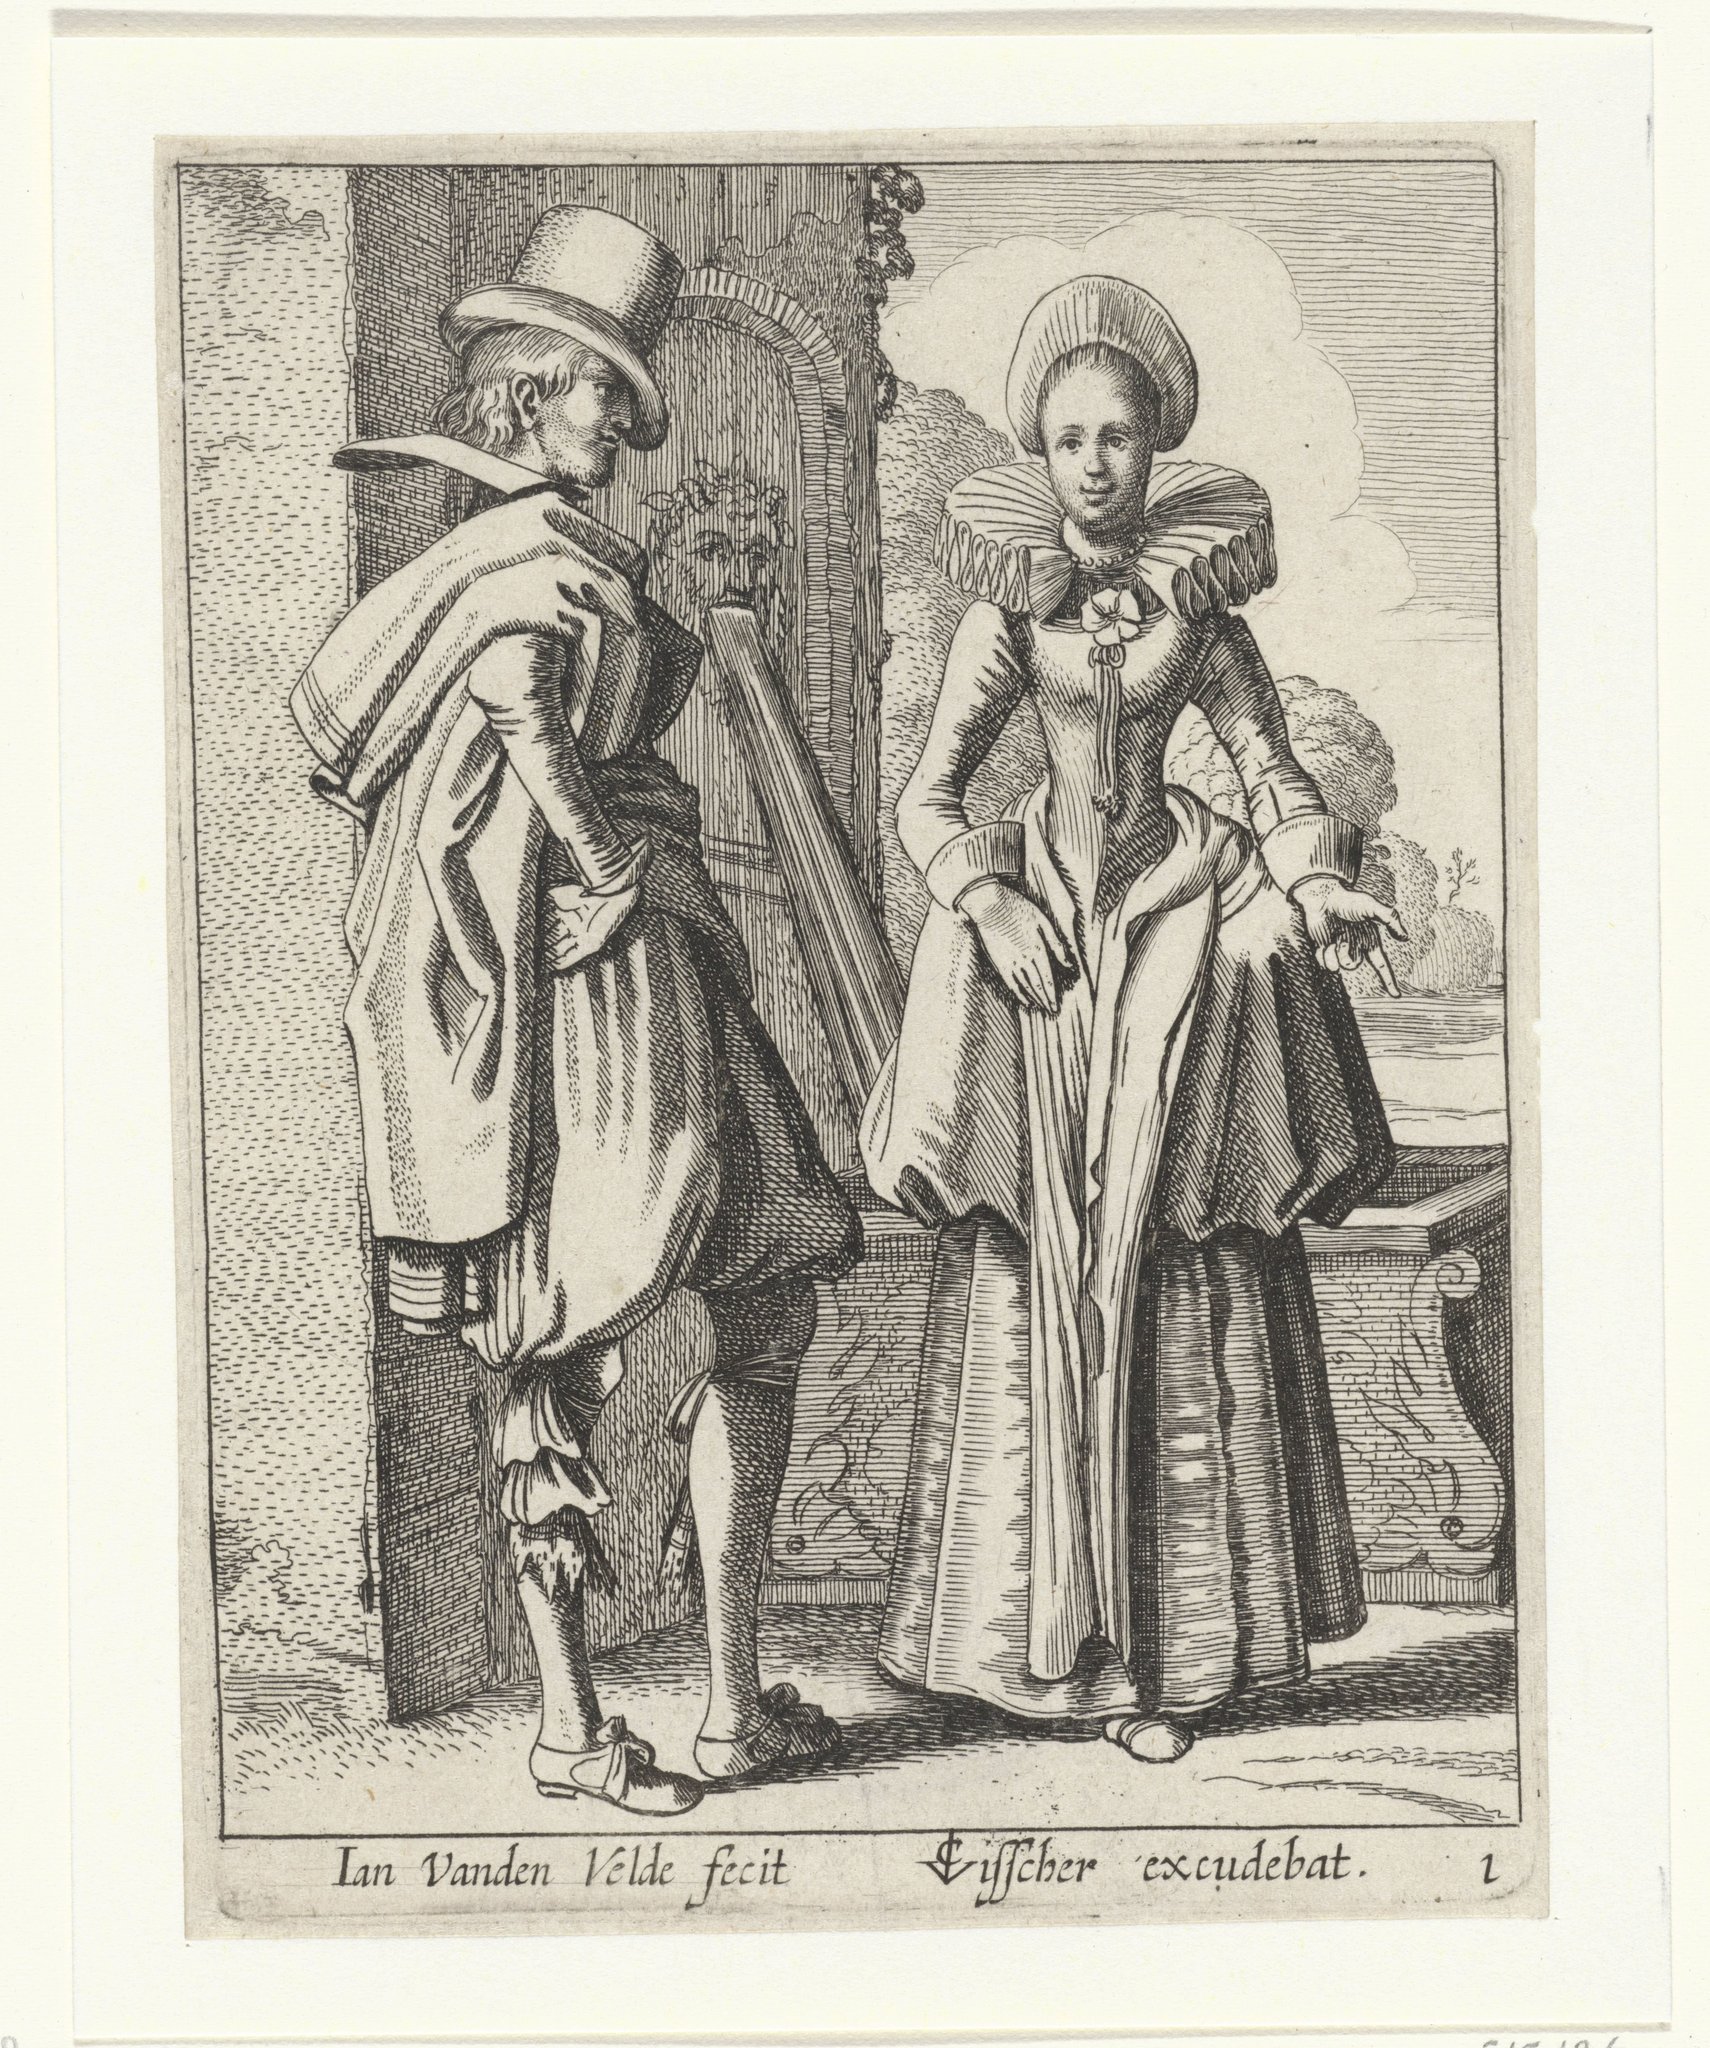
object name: costume print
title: Kostuums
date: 1603-1652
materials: paper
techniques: engraving, etching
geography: amsterdam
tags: brooch, agraffe, clasp (+ women's clothes), cape (+ men's clothes), head-gear (boogmuts) (+ women's clothes), head-gear: hat (+ men's clothes), clothes, costume (+ women's clothes), neck-gear ~ clothing (with name) (+ women's clothes), skirt (+ women's clothes), sleeves: cuffs (+ women's clothes), shoes, sandals (+ men's clothes), clothes, costume (+ men's clothes), neck-gear: collar (+ men's clothes), trousers, breeches, etc. (breeches) (+ men's clothes), clothing for the upper part of the body (doublet) (+ men's clothes), sleeves (+ women's clothes), clothing for the upper part of the body (with name) (+ women's clothes), netherlands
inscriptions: signature: ‘Ian Vanden Velde fecit’, number: ‘1’, collector's mark: Lugt 964, address: ‘CVisscher excudebat.’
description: kleding man: hoed met cilindervormige bol / gladde waaiervormige kraag / mantel met siermouwen / tot knie reikende wijde pofbroek / kniebanden met grote strik / lage schoenen met hak en striksluiting. Vrouw: diadeemmutsje / open lubbenkraag / nauwe mouwen met trechtervormige ponchetten / strak puntlijf met rozet / opengeslagen rok